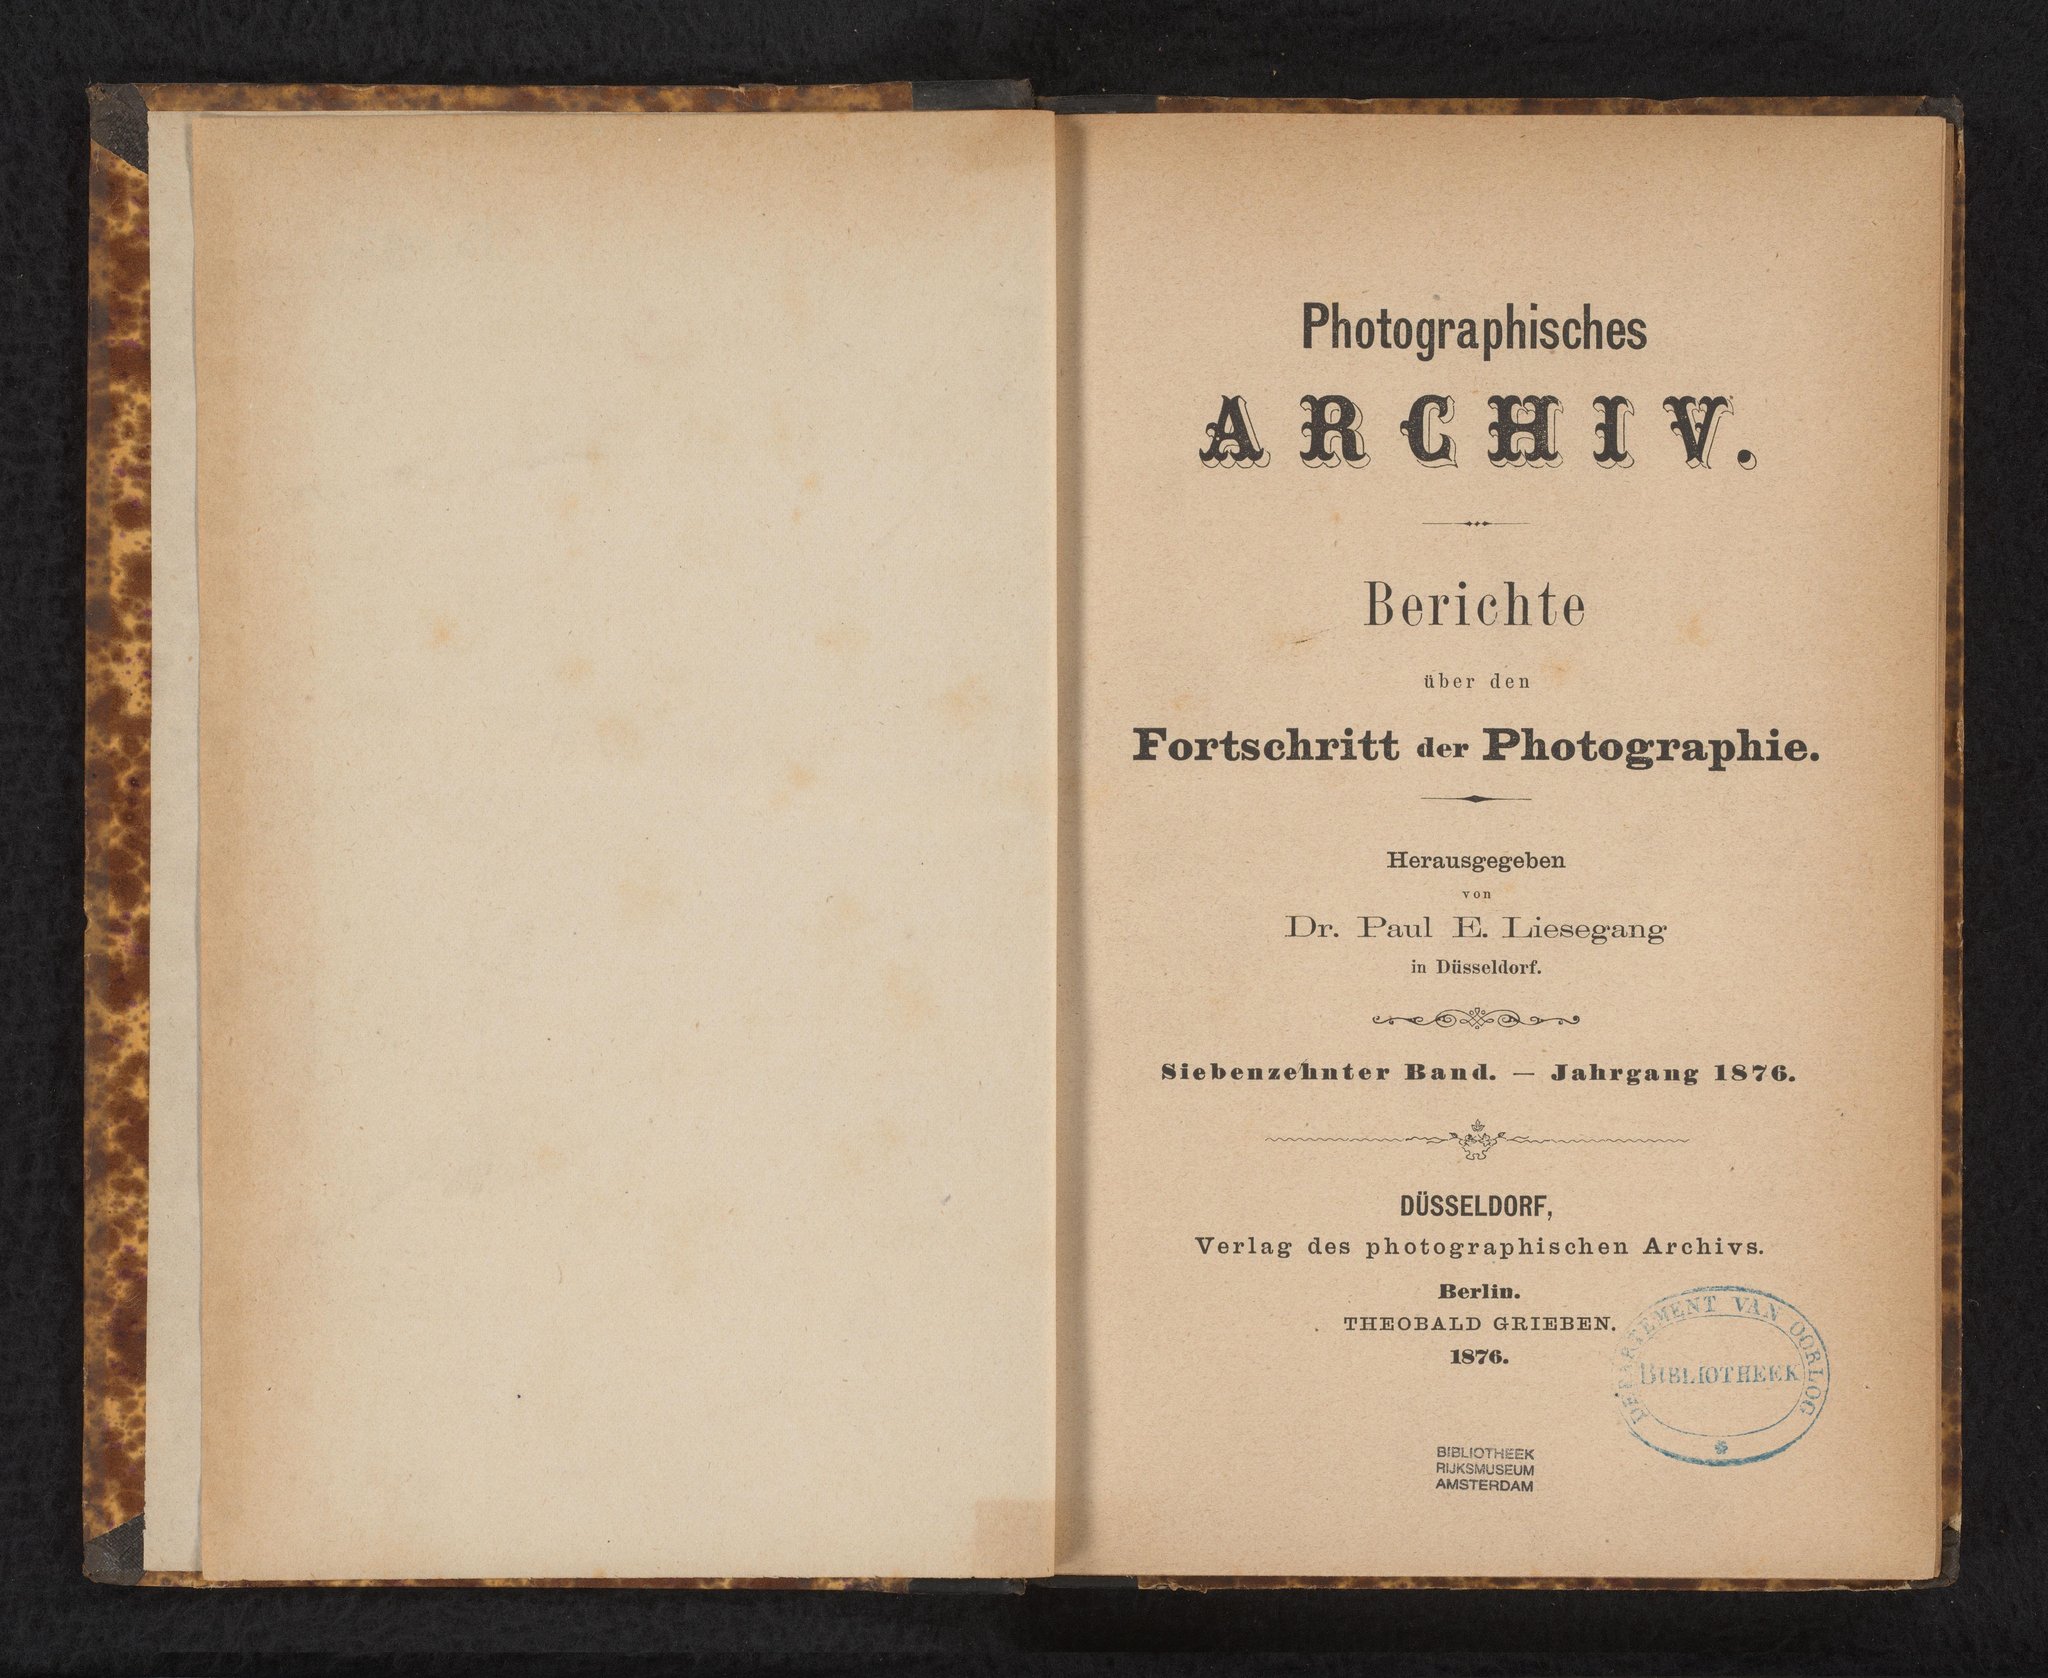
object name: book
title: Photographisches Archiv. Siebenzehnter Band - Jahrgang 1876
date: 1876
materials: cardboard, leather, paper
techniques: engraving, letterpress printing, marbling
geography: berlin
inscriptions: stamp: ‘Departement van oorlog/ Bibliotheek’, number: ‘1913’